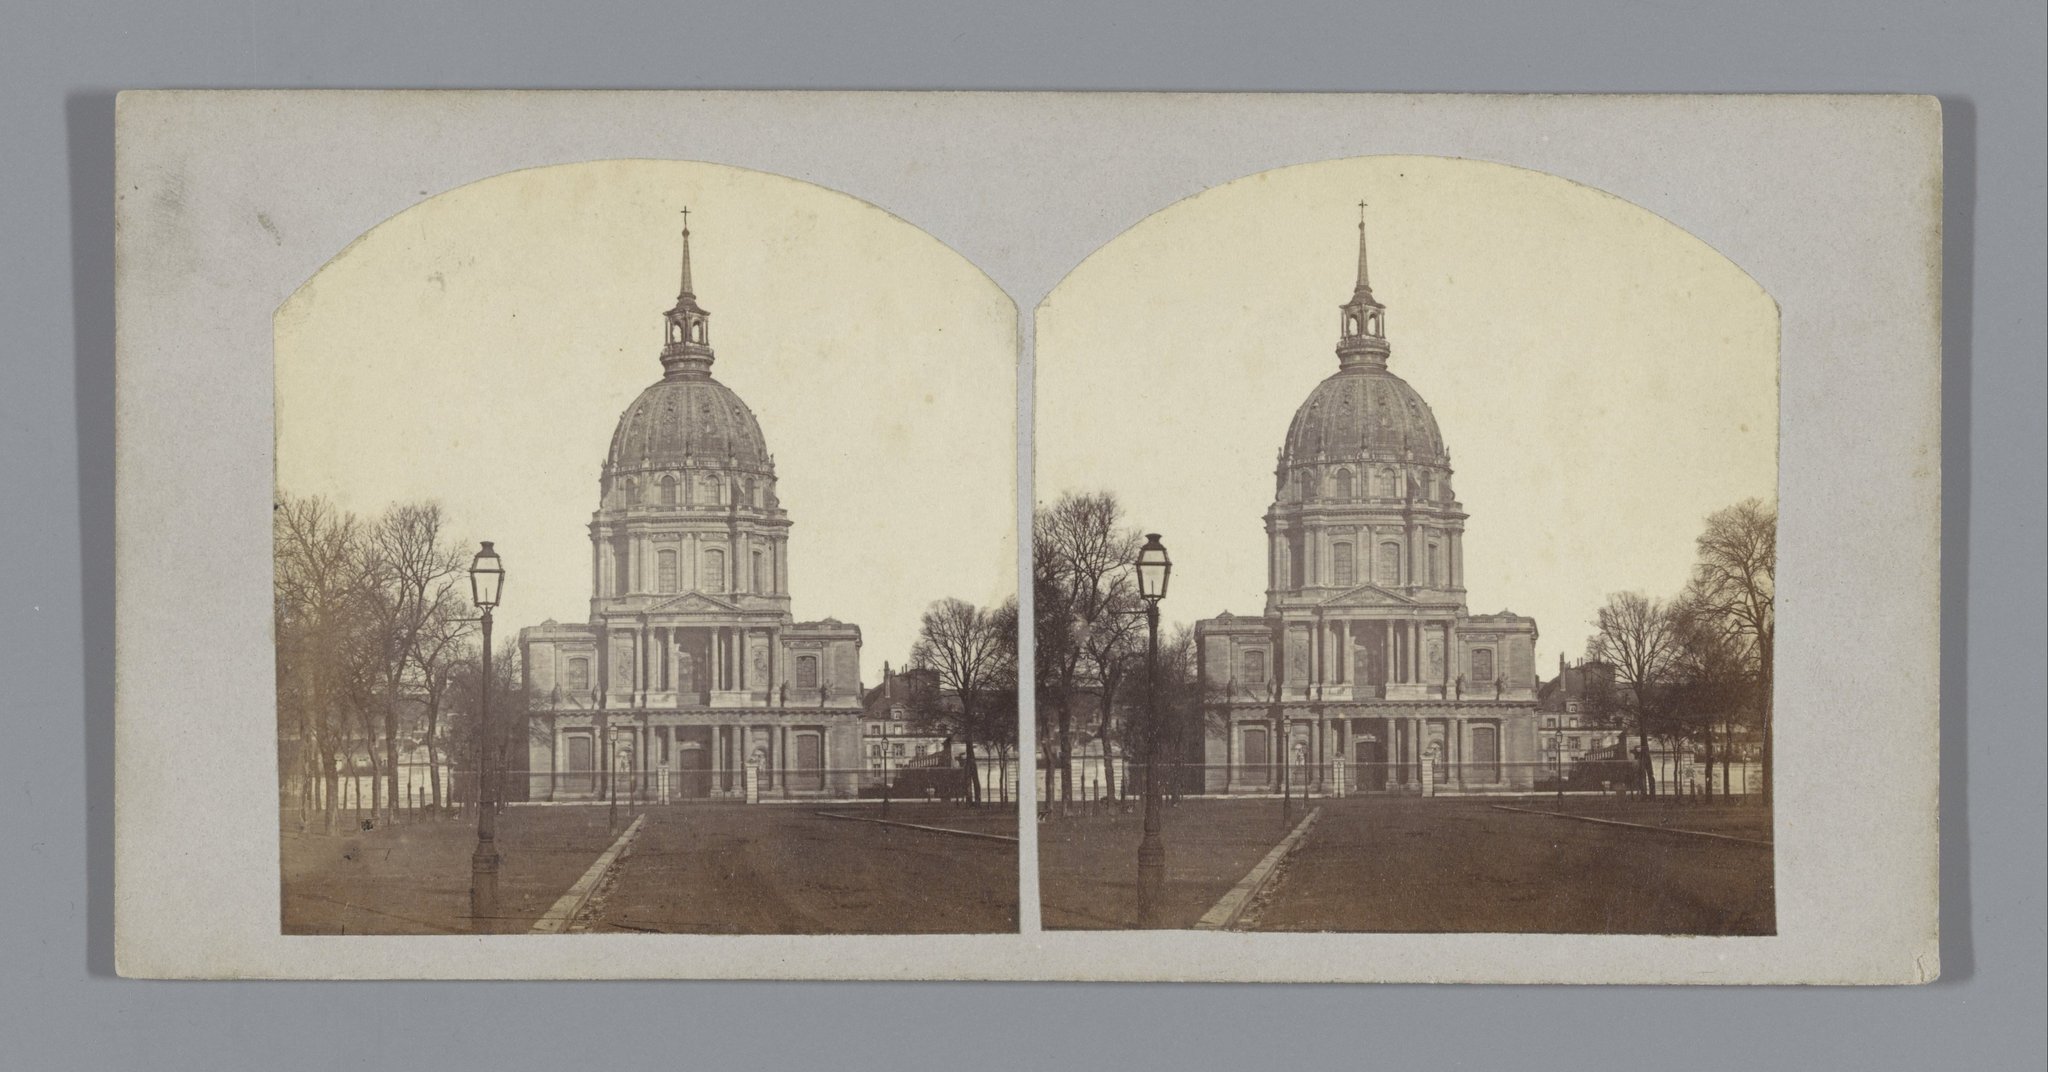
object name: stereograph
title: Hotel des Invalides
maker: Anonymous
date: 1860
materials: cardboard, photographic support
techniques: albumen print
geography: paris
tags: monument, statue